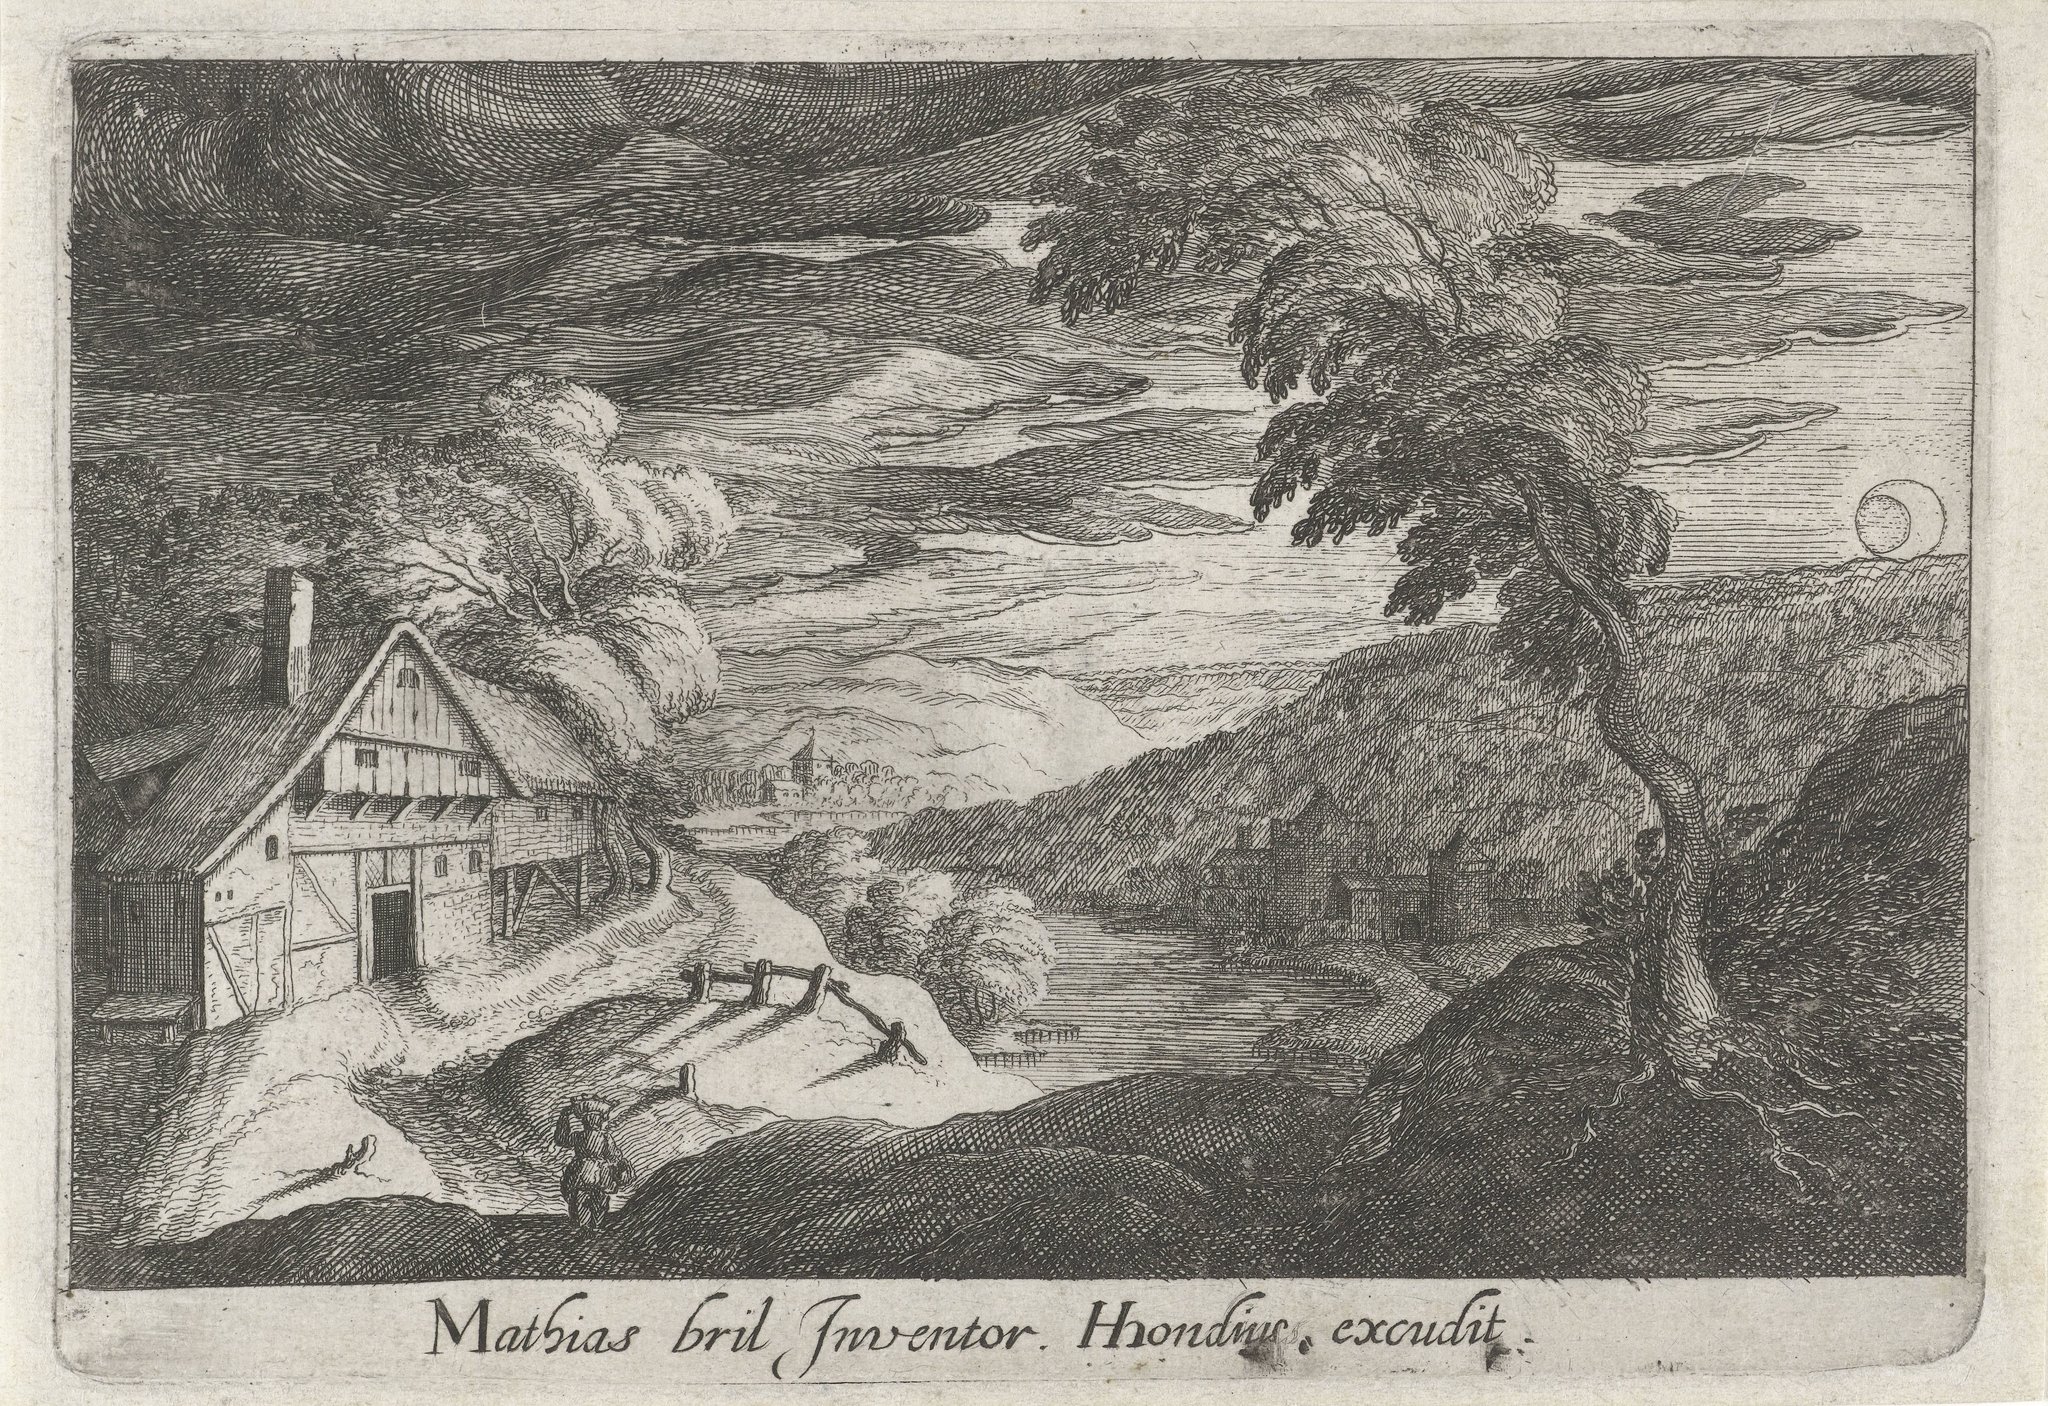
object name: print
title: Landschap bij maanlicht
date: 1614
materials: paper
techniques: etching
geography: the hague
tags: landscapes (+ landscape with figures, staffage)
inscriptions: collector's mark: Lugt 2228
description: Landschap bij maanlicht met links op de voorgrond een boerderij en in het midden een rivier.